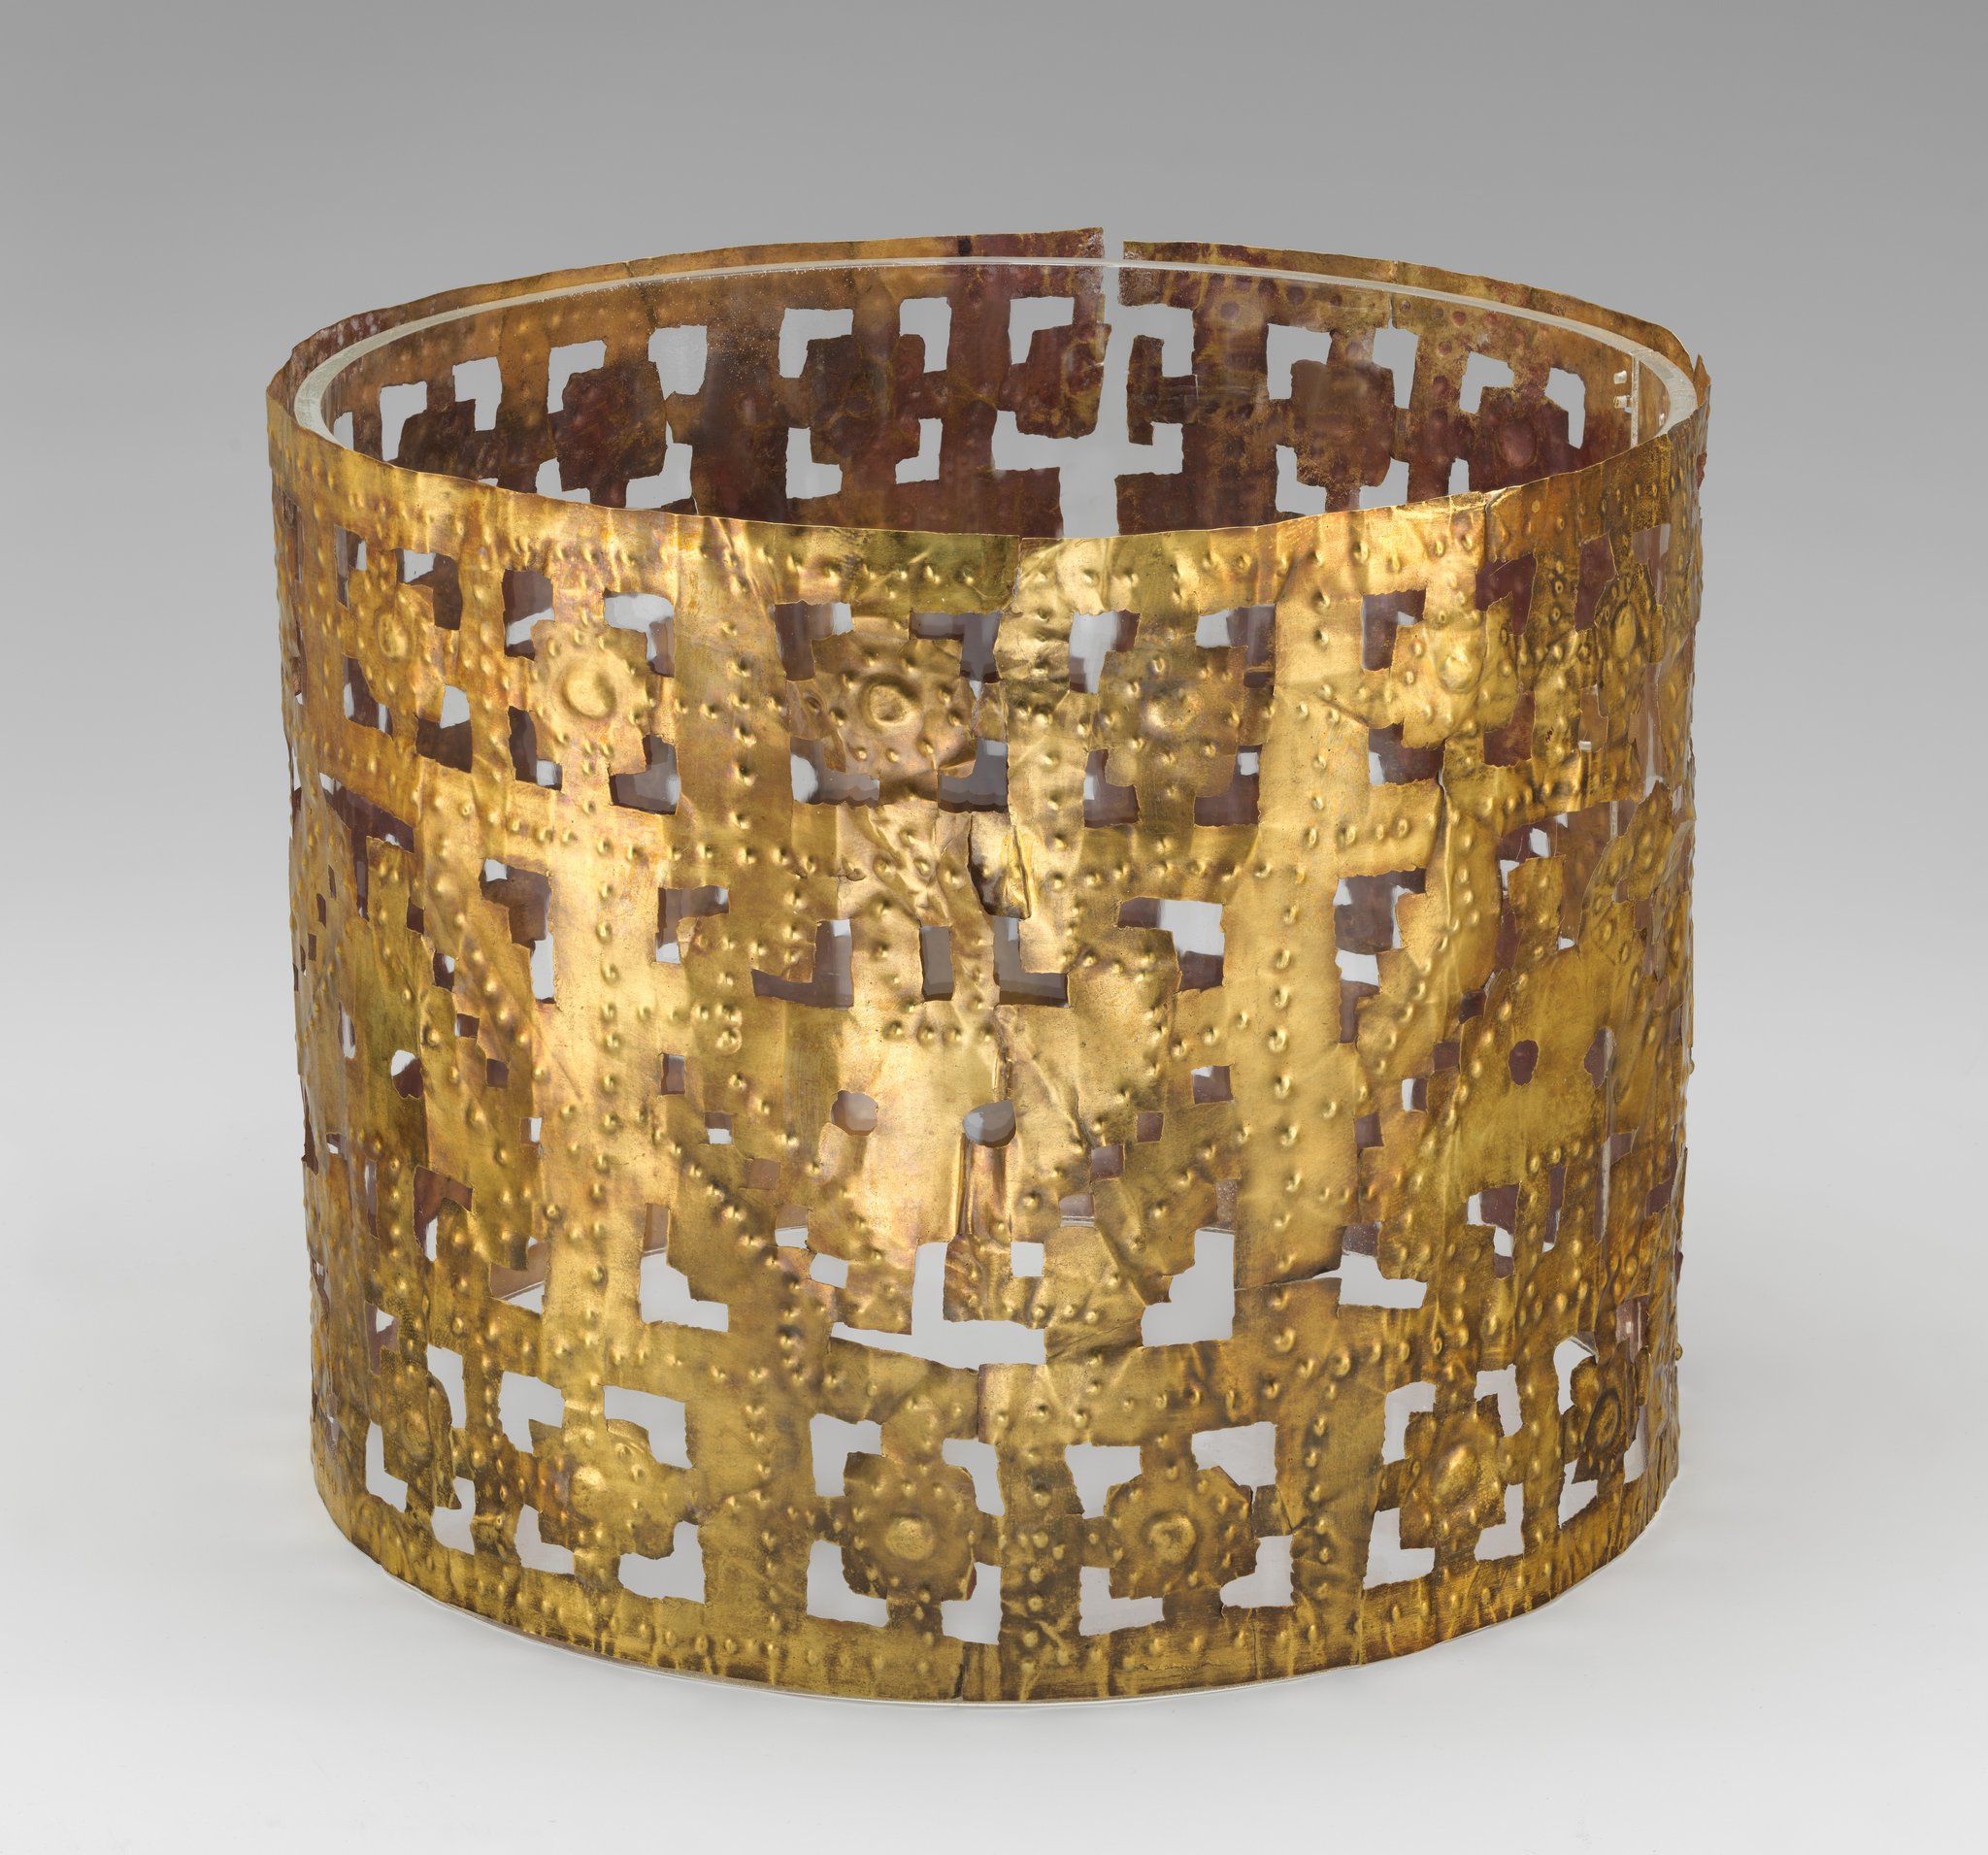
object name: crown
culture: chimú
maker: north coast artist(s)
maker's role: artist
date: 800-1400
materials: gold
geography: peru